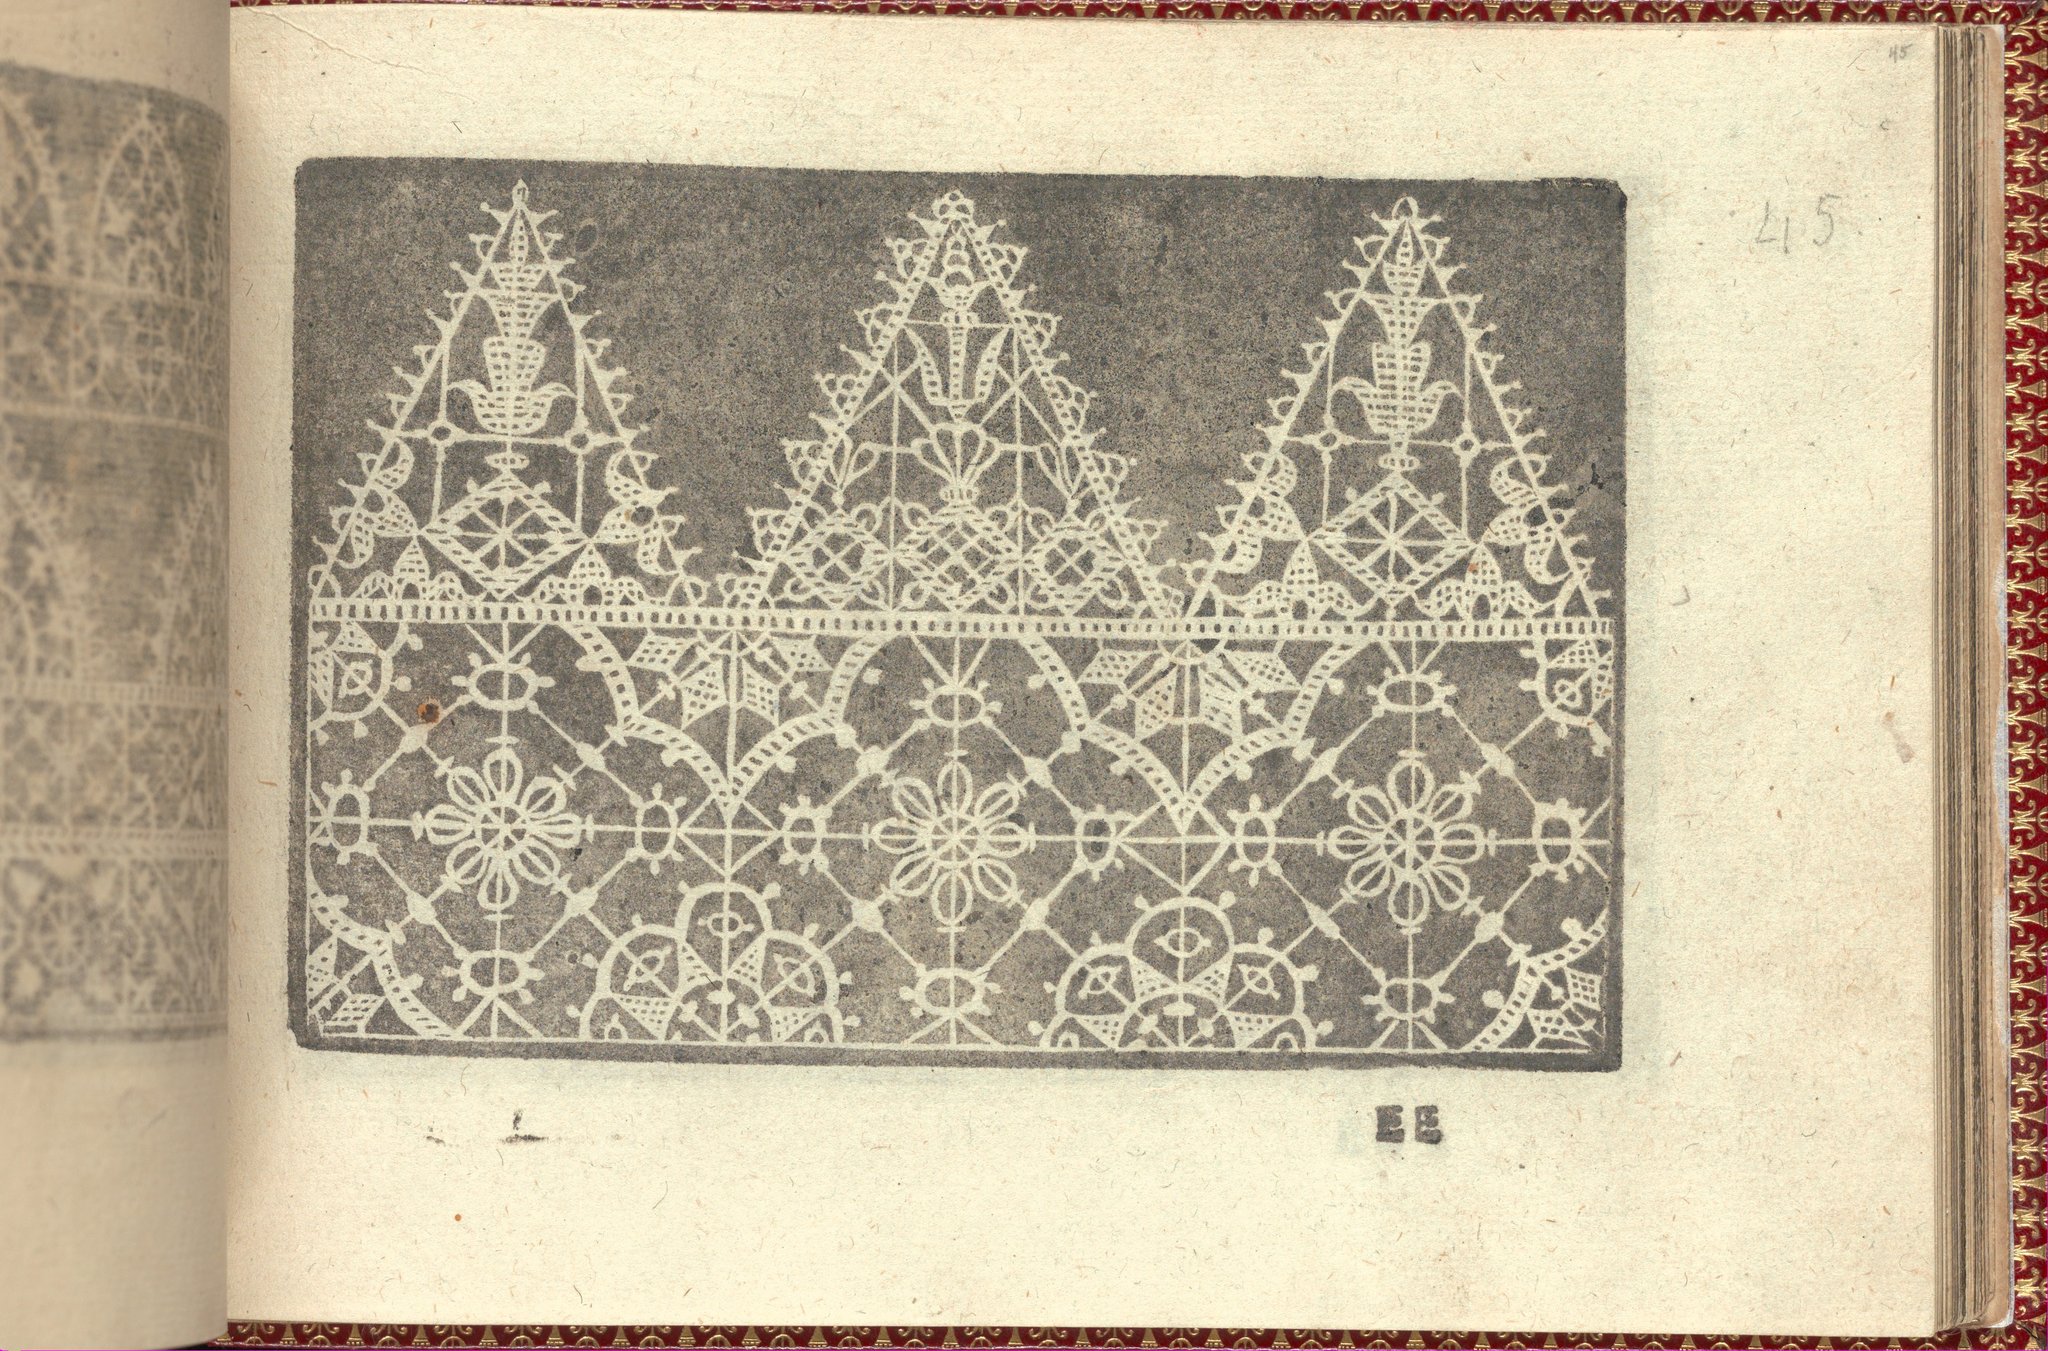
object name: book print ornament architecture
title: Corona delle Nobili et Virtuose Donne: Libro I-IV, page 45 (recto)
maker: cesare vecellio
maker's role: publisher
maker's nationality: italian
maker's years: 1521-1601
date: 1601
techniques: woodcut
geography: italy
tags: ornament